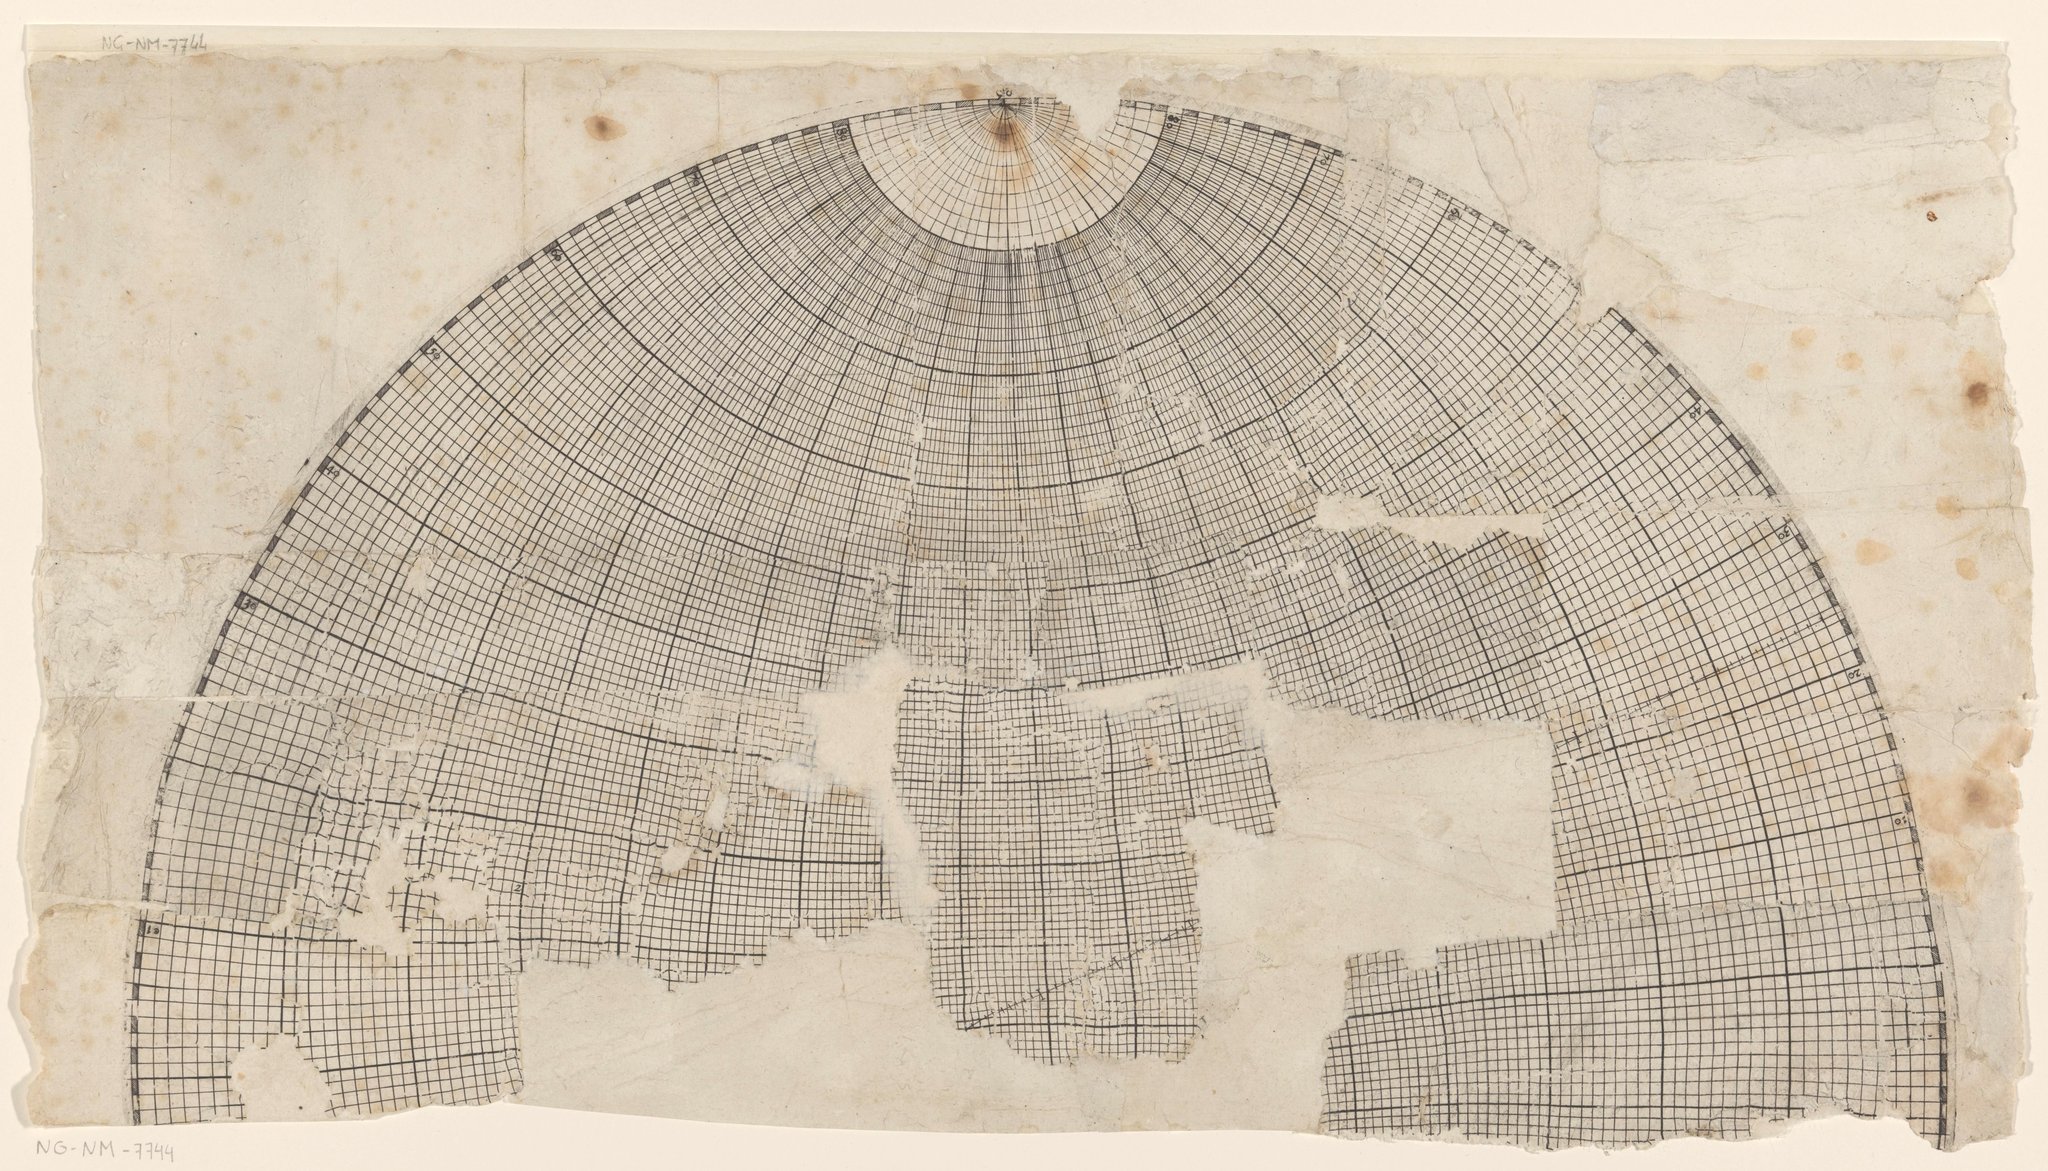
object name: print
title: Kaartnet van noordelijk halfrond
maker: Anonymous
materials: paper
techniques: engraving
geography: northern netherlands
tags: maps, atlases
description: De prenten en kaarten in de Nova Zembla collectie zijn tijdens een expeditie van Willem Barendsz en Jacob van Heemskerk in 1596-1597 noodgedwongen in het winterkamp, het ‘Behouden Huis’, op het eiland achtergelaten. Bijna drie eeuwen later, in 1871, keerde de Noor Elling Carlsen terug naar Nova Zembla en vond daar de restanten van het ‘Behouden Huis, inclusief een groot deel van de inventaris. Een deel van de prenten, in de vorm van aaneengekoekte kluiten, werd toen ook teruggevonden. De papierkluiten waren soms op meerdere plekken gebroken. Tussen 1975-1979 zijn de prenten van elkaar gescheiden. Dit leverde in totaal ca. 1000 fragmenten van ca. 400 afdrukken van ca. 150 verschillende prenten op. Voor zover mogelijk zijn de fragmenten samengevoegd en zijn de prenten gereconstrueerd.